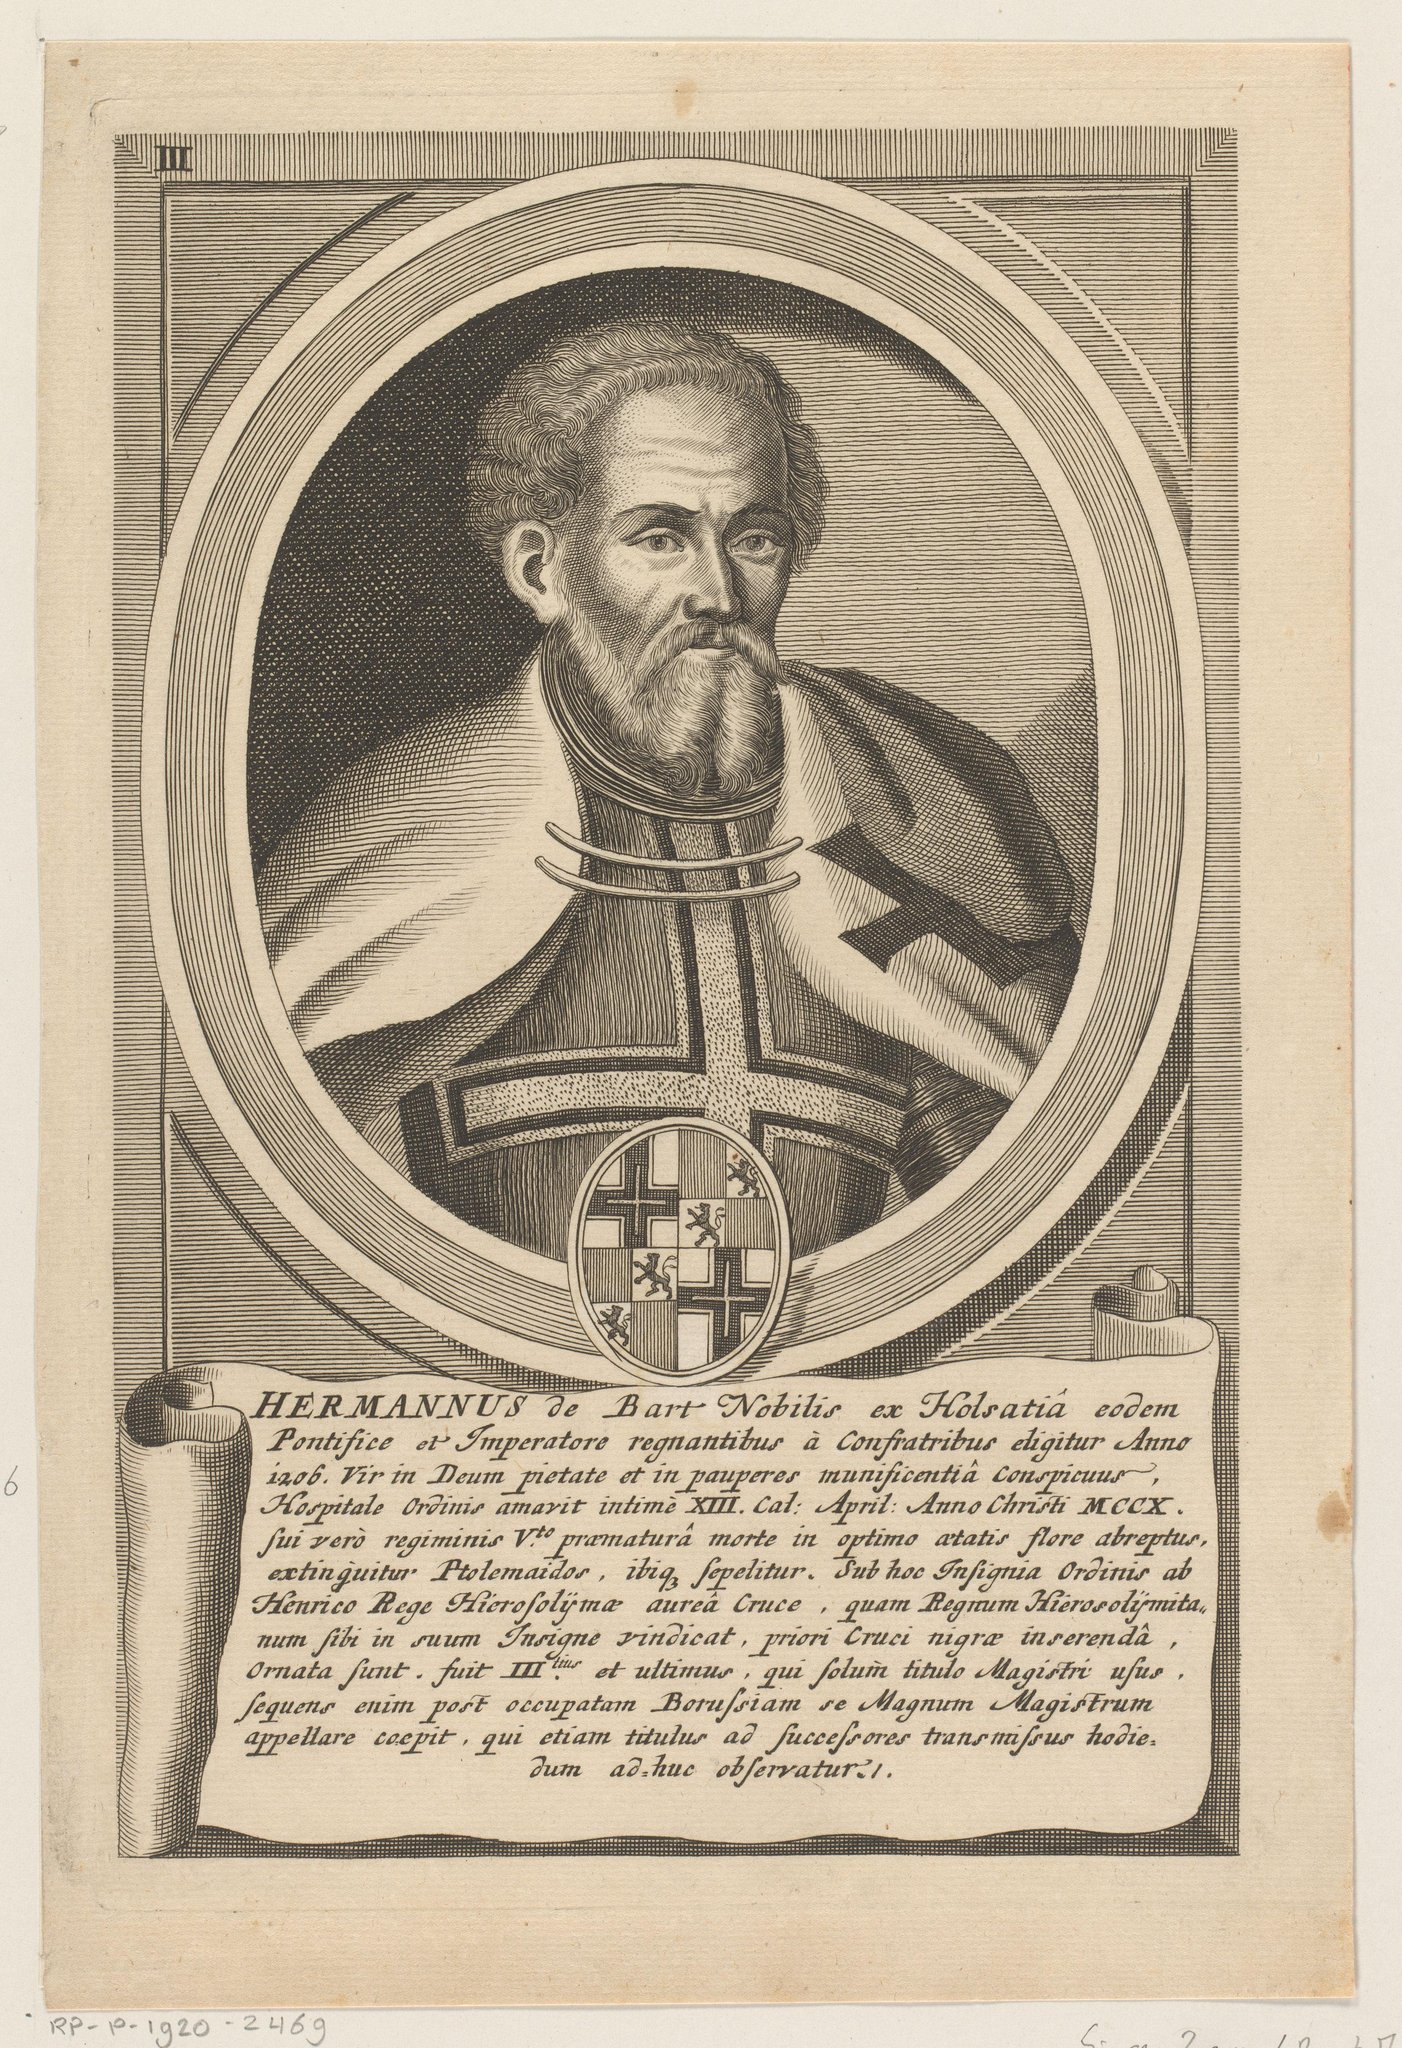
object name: book illustration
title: Hermannus de Bart Nobilis ex Holsatia (...)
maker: johann salver (i)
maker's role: print maker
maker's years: 1670-1738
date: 1720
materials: paper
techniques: engraving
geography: würzburg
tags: knighthood order: teutonic order - insignia of a knighthood order, e.g.: badge, chain (with name of order), historical persons, armorial bearing, heraldry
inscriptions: collector's mark: Lugt 2228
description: Prent uit: [Salver, Johann]. De origine, secundis et adversis successibus, nec non de statu moderno inclyti ordinis equestris hospitalis b.m.v. Teutonicorum in Jerusalem. Würzburg: Johann Salver, [ca. 1720].